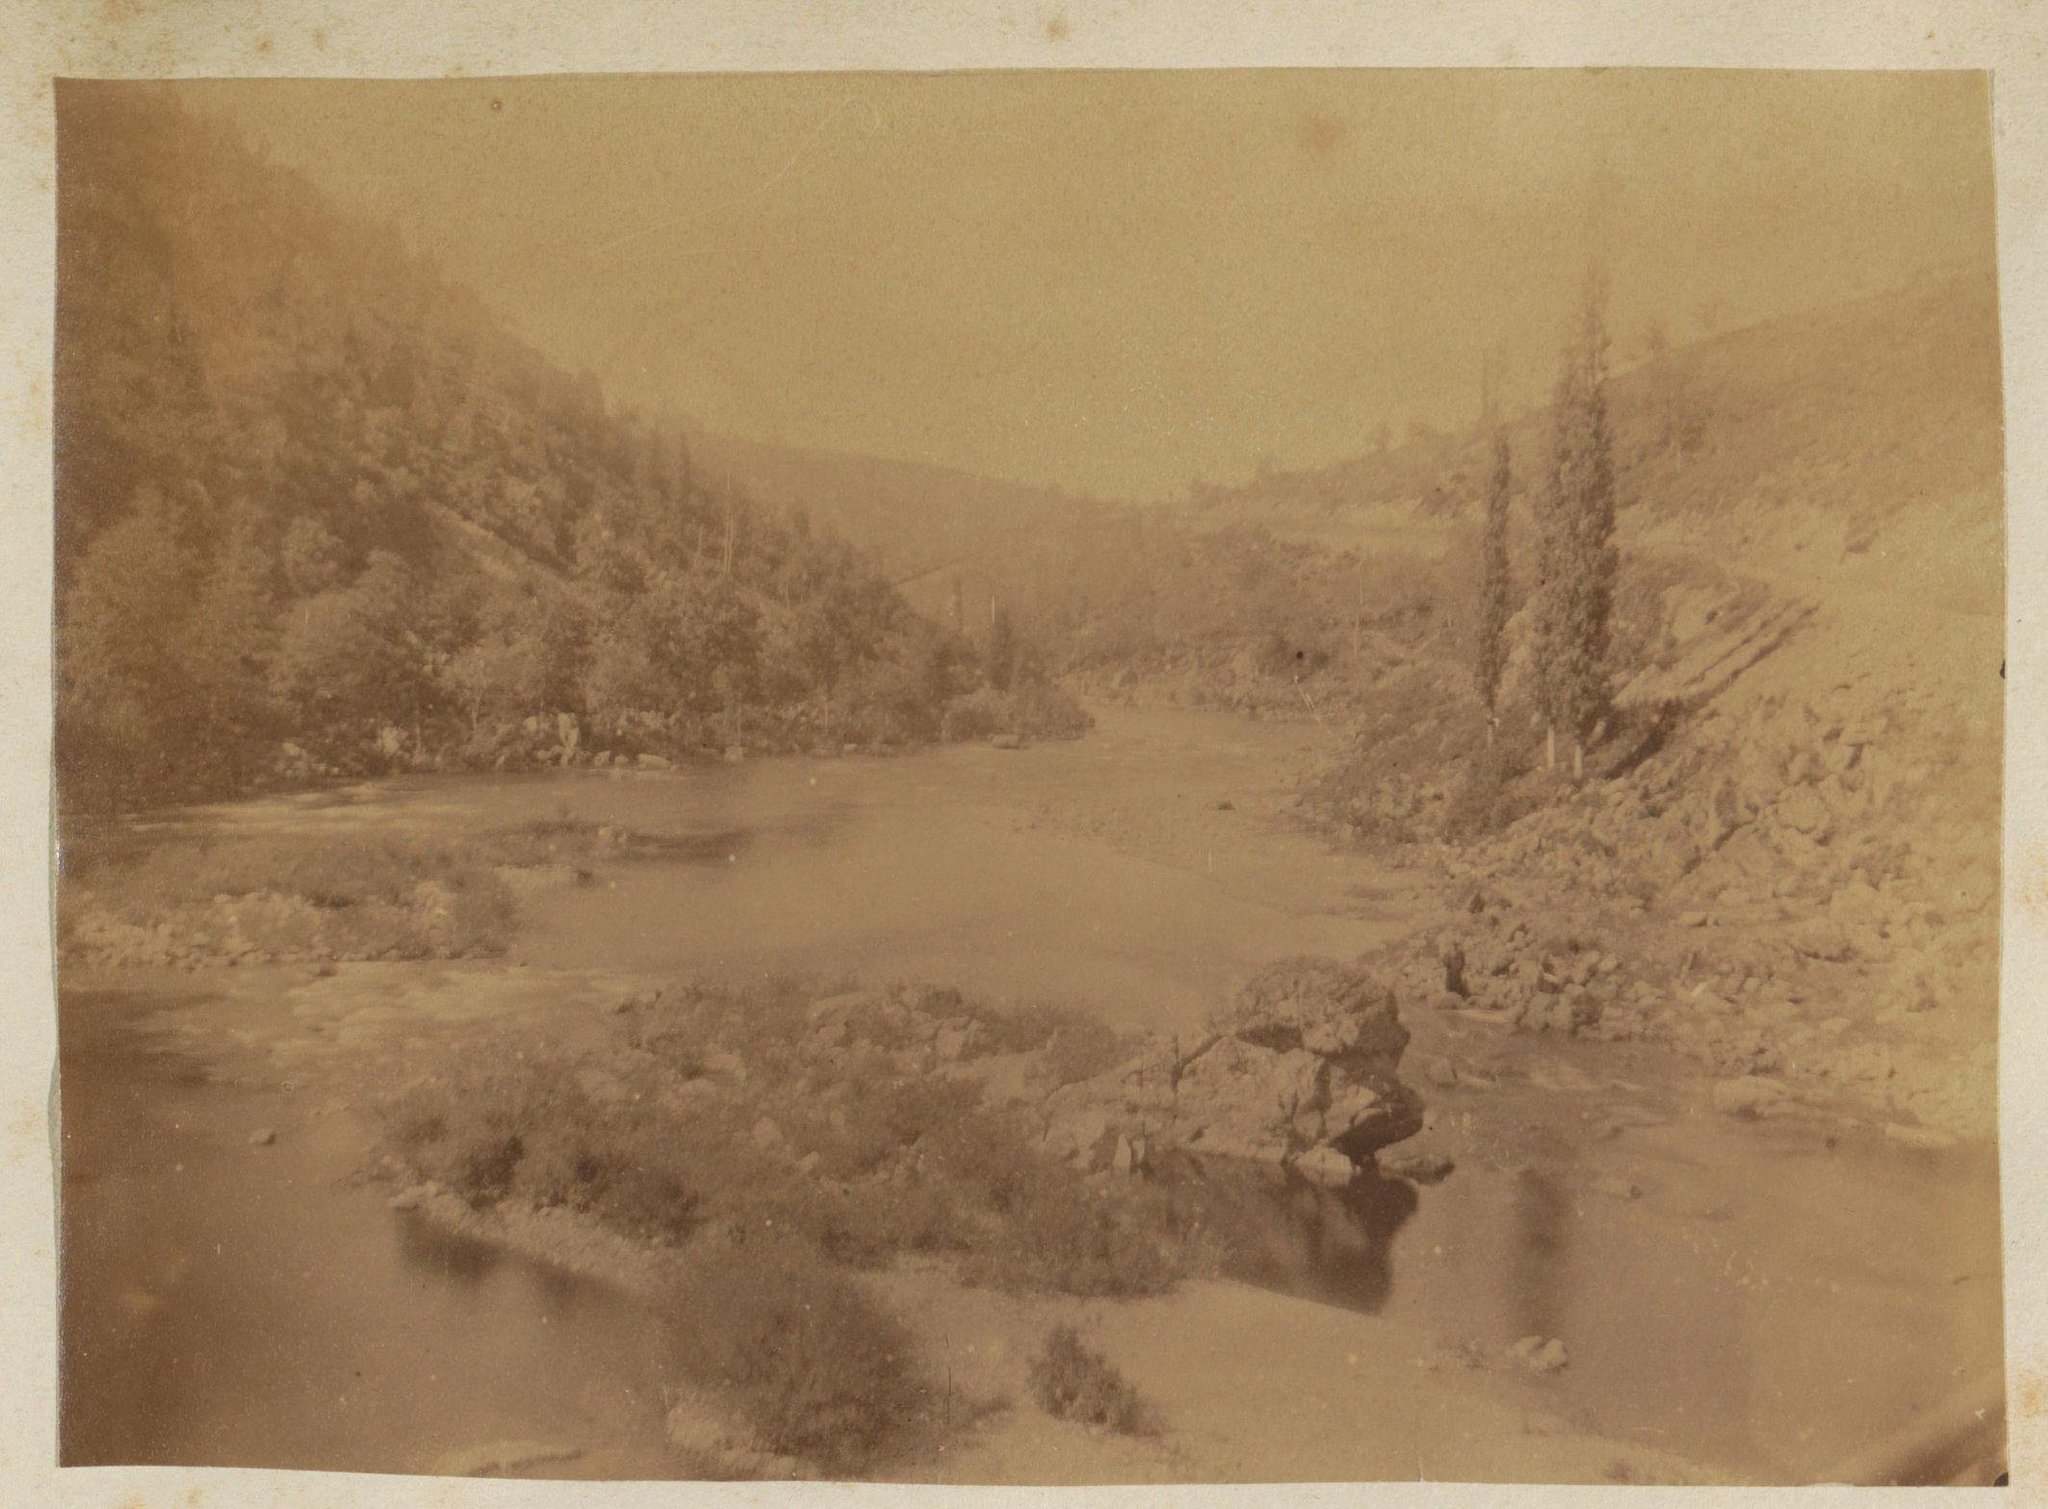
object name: photograph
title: Riviergezicht in Frankrijk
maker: Anonymous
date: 1805-1883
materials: photographic support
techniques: albumen print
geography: france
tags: river (+ landscape with figures, staffage), france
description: Onderdeel van Album van een Franse amateurfotograaf met opnames van familie, militairen, industrie, landschappen en bezienswaardigheden in Frankrijk.